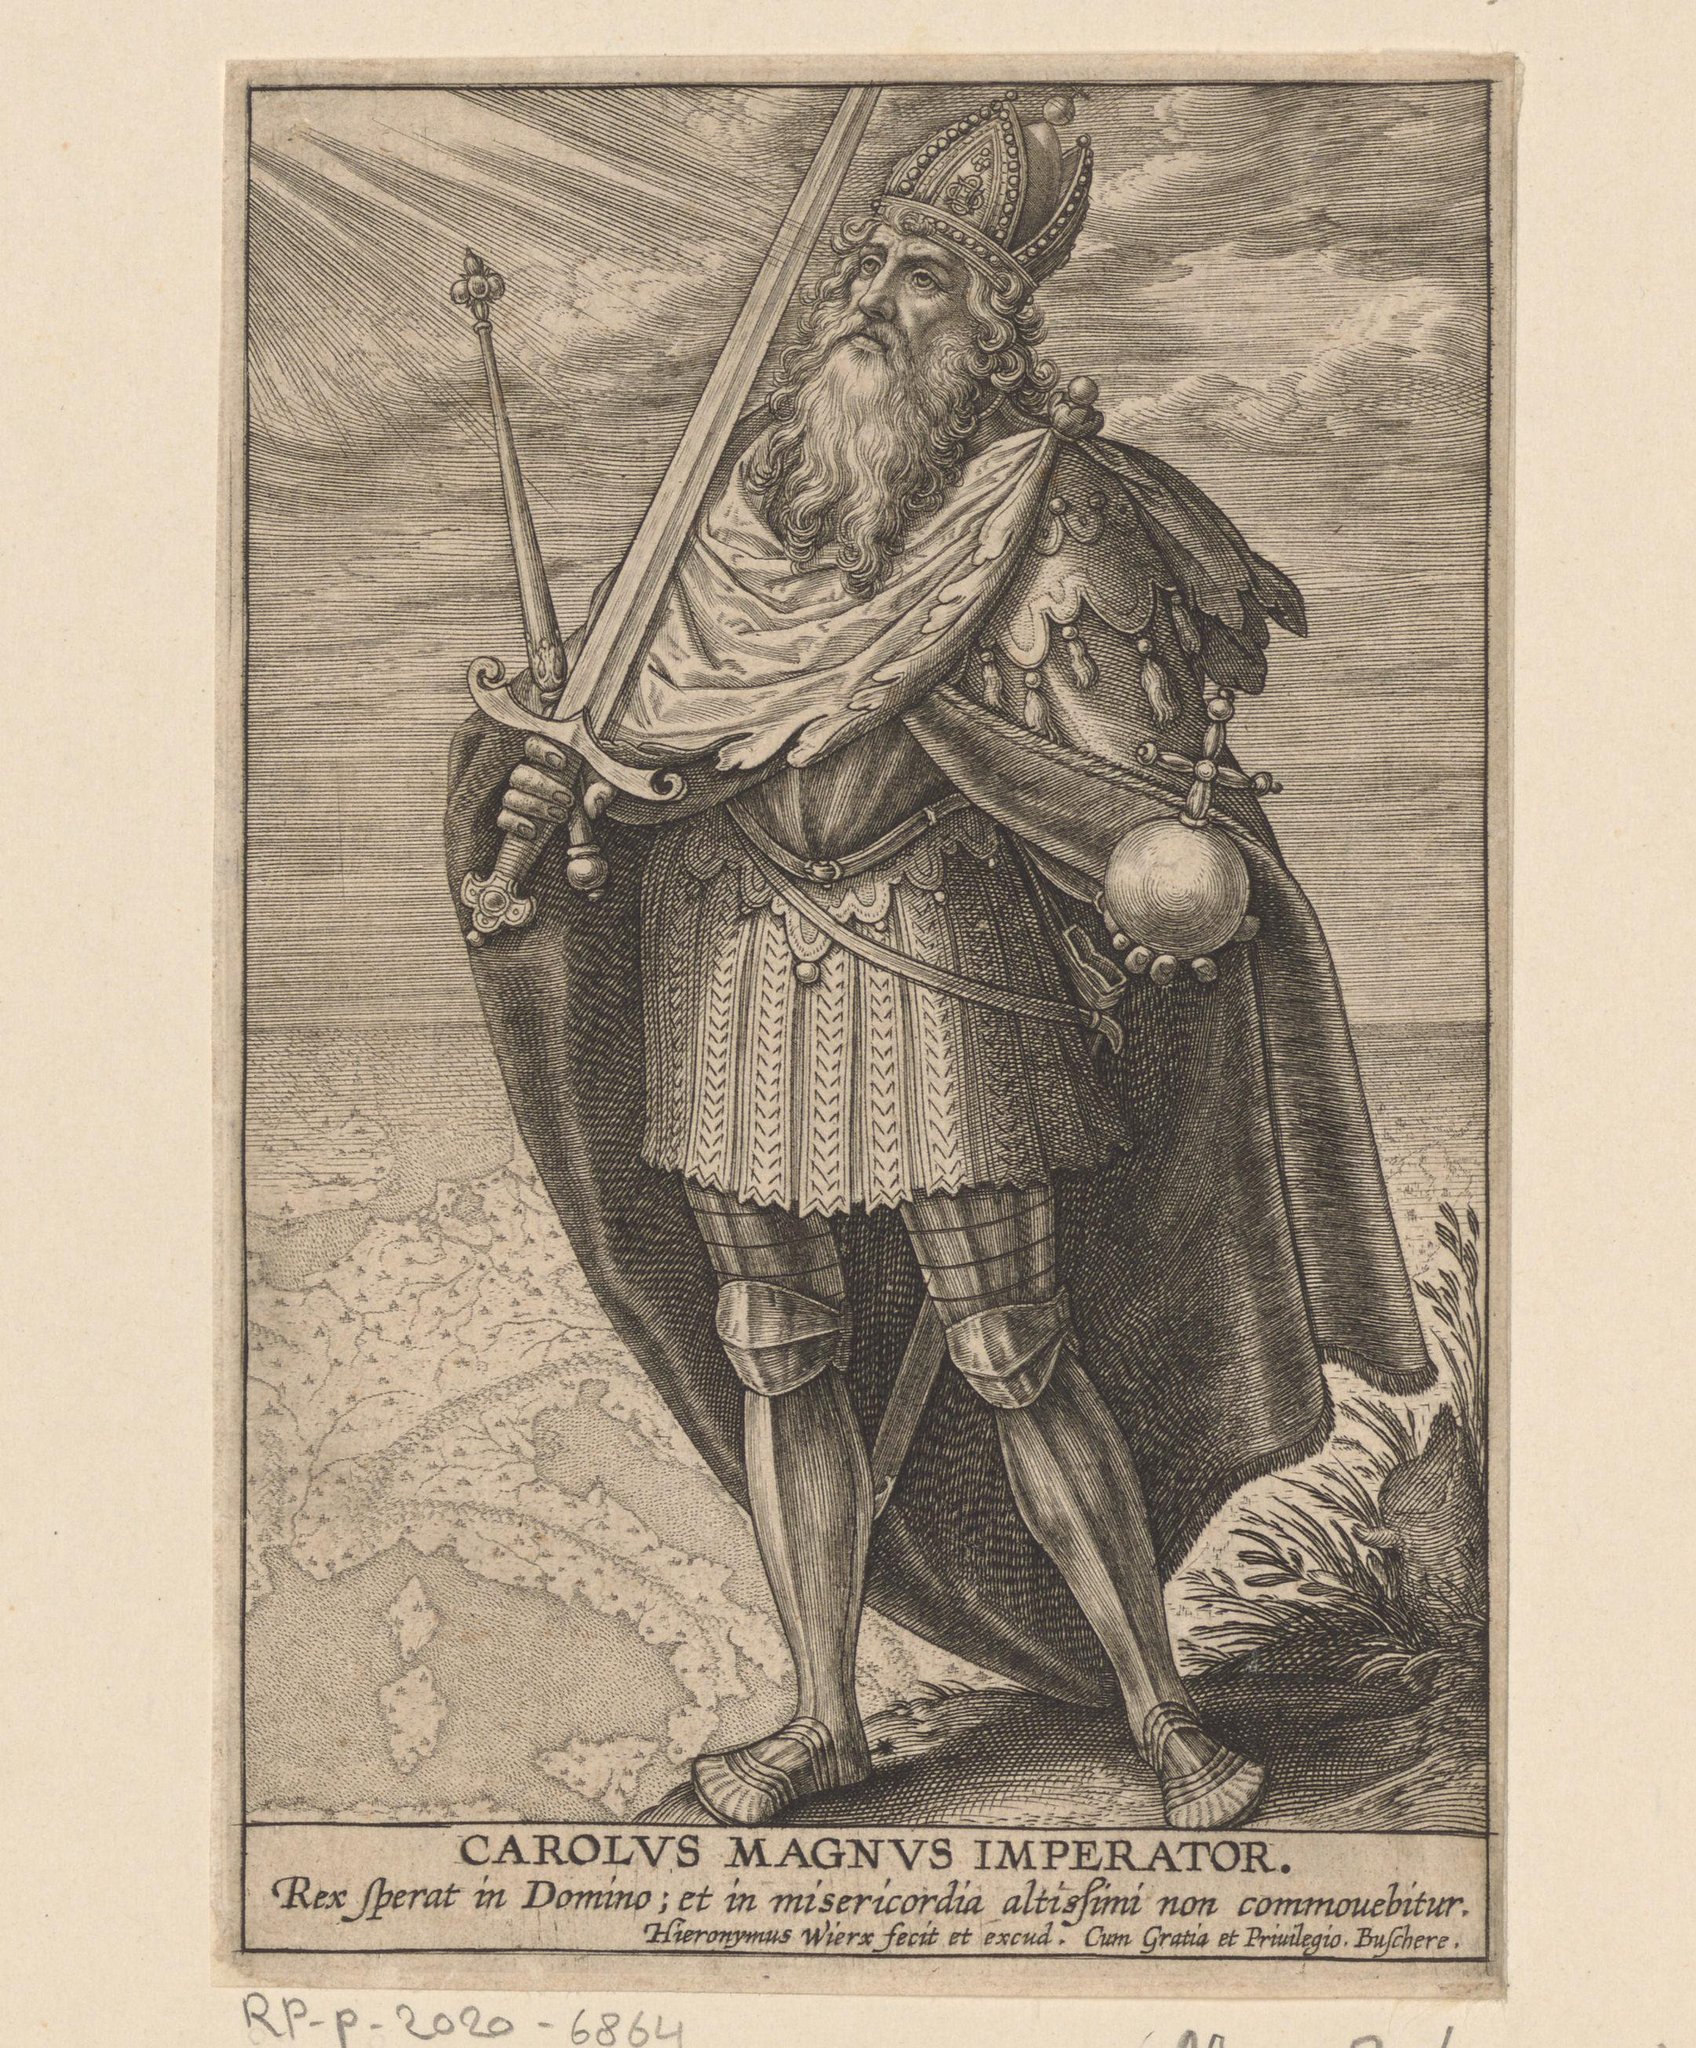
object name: print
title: Portret van Karel de Grote, keizer van het Heilige Roomse Rijk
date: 1563-1619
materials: paper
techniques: engraving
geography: antwerp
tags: charlemagne (holy roman emperor), historical persons, king